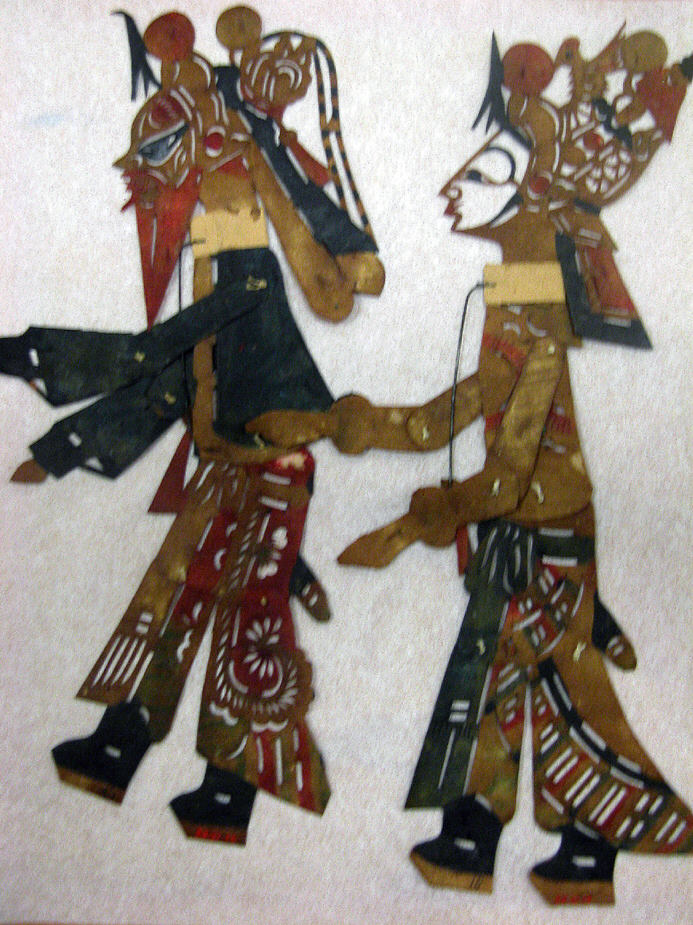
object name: shadow player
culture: chinese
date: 1801-1900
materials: cord, skin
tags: human figures,masks